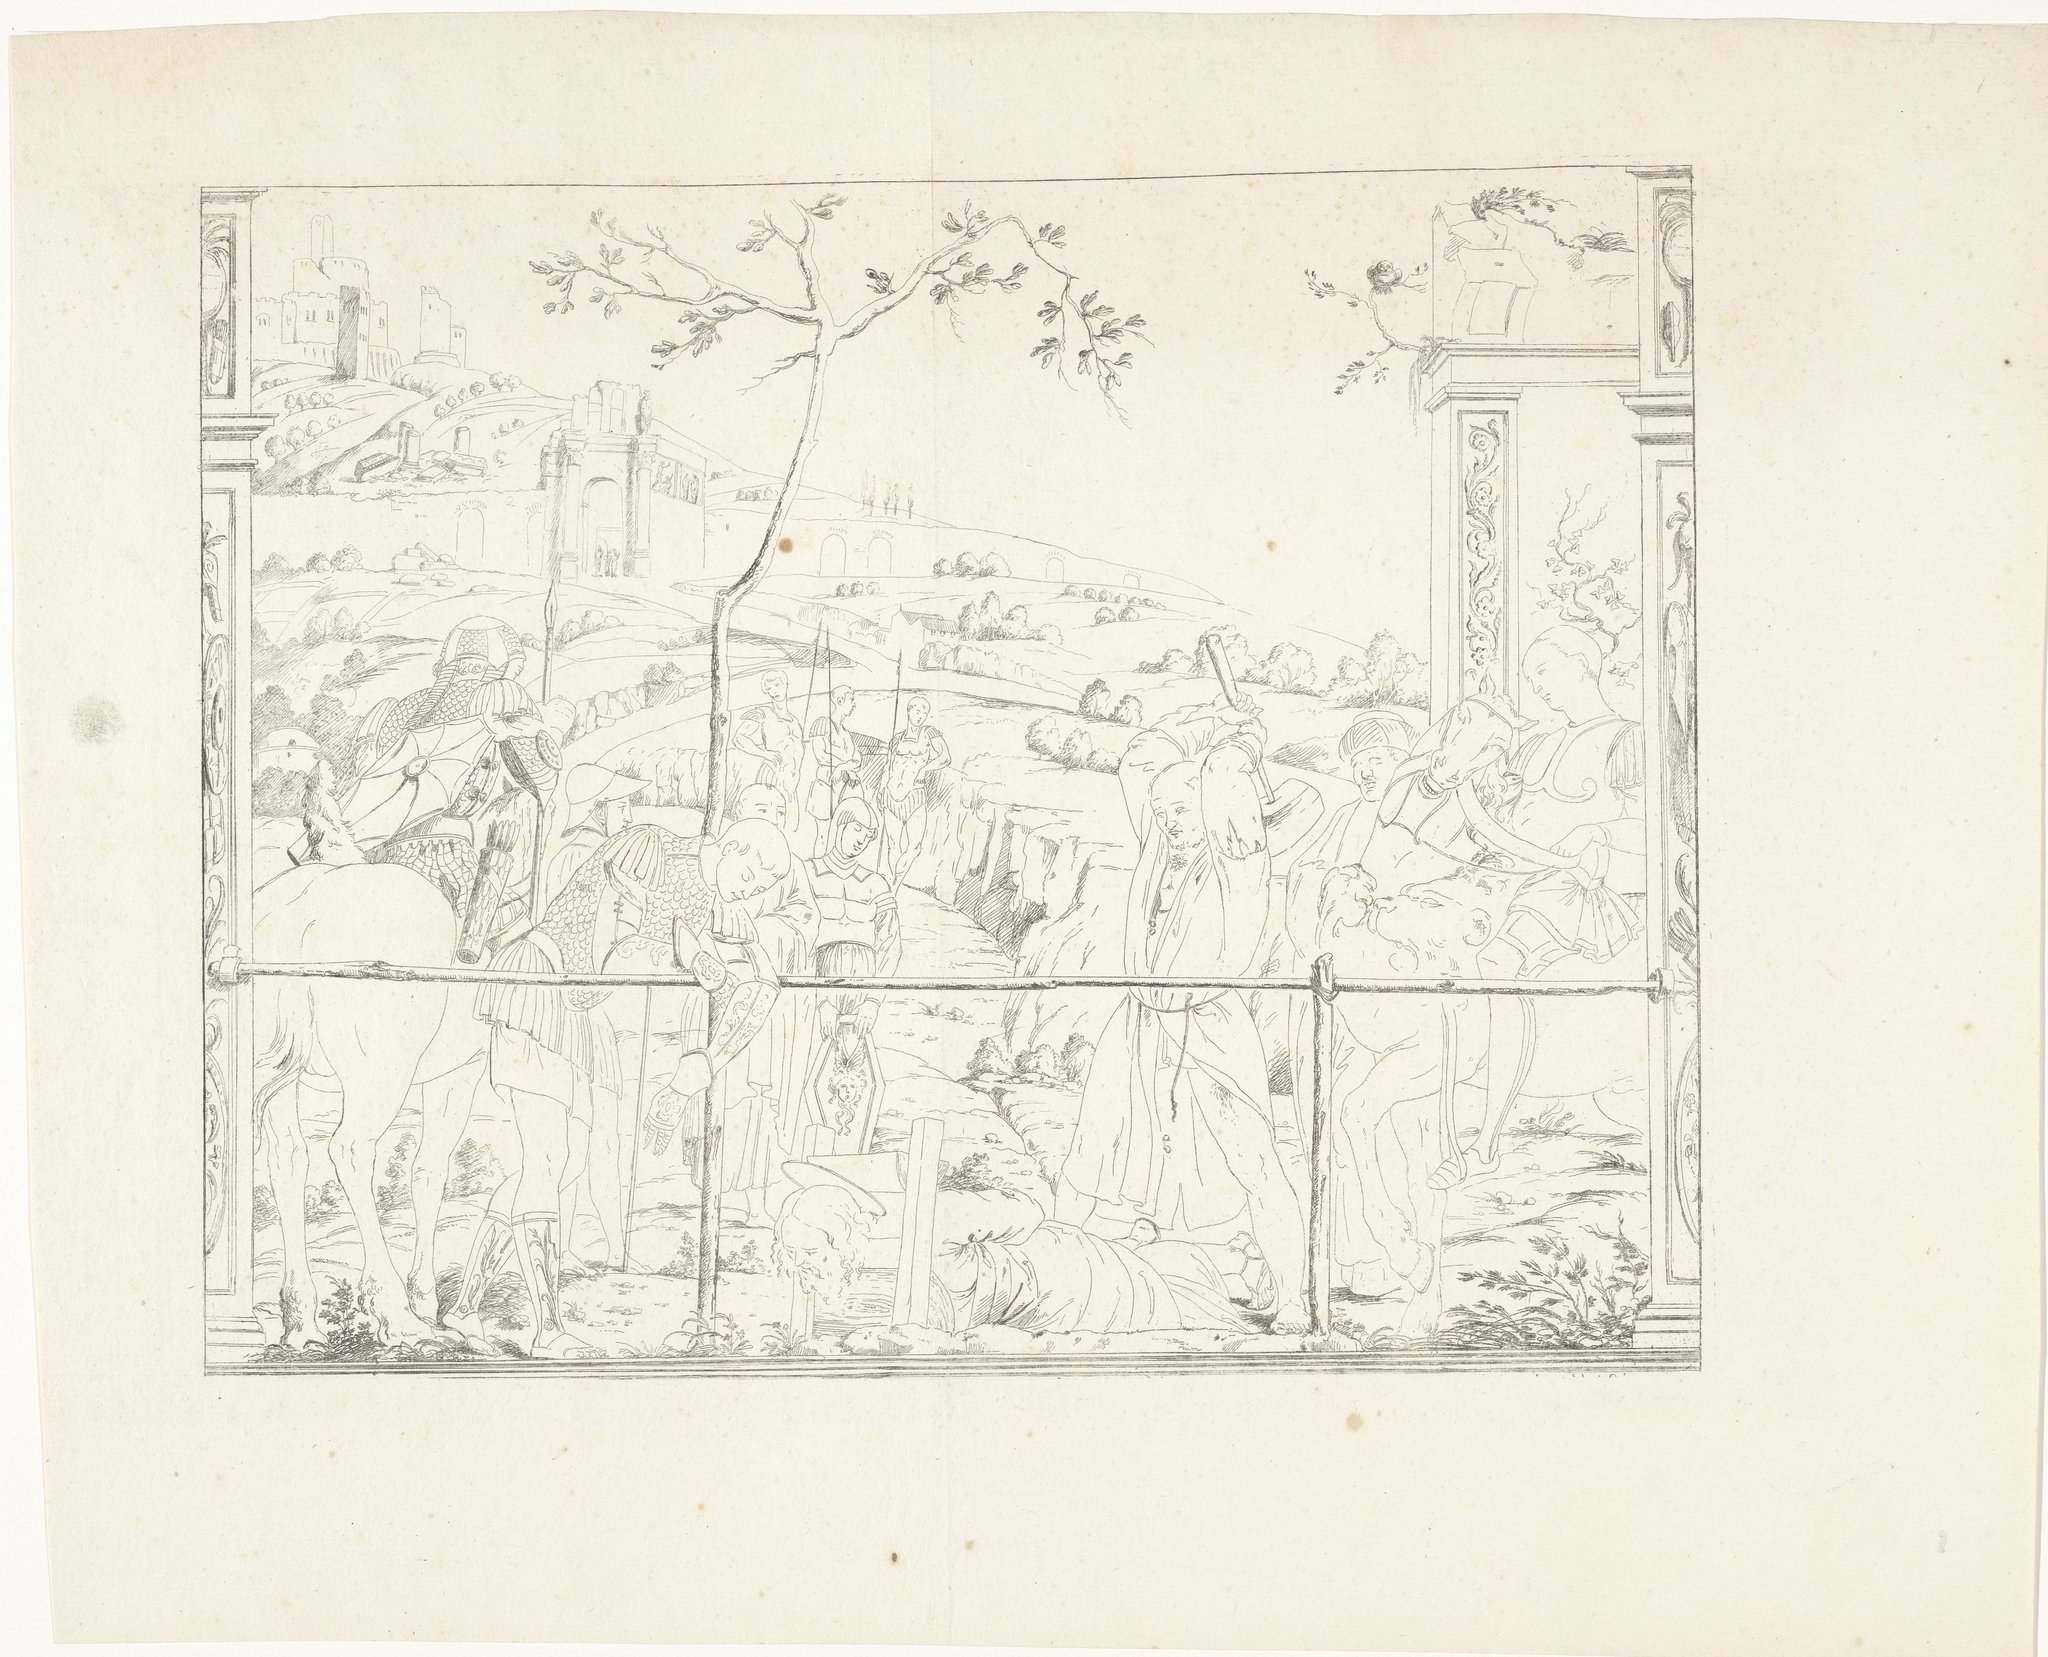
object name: print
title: Martelaarschap van de heilige Jakobus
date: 1776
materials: paper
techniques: printmaking, etching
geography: padua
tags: beheading of james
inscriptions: collector's mark: Lugt 2228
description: Prent uit een reeks van vier prenten (+ titelprent) met weergaven van de fresco's van Andrea Mategna in de Chiesa degli Eremitani in Padua (fresco's zijn vernietigd tijdens bombardement 11 maart 1944). Contra-épreuve van de lijnets zonder tekst. De unieke(?) contra-épreuves in het RPK geven Mantegna's voorstellingen in dezelfde richting weer. Contra-épreuves niet bekend bij Newcome-Schleier en Grasso; zie F. Carlo Schmidt in Print Quarterly 21 (2004), p. 469.